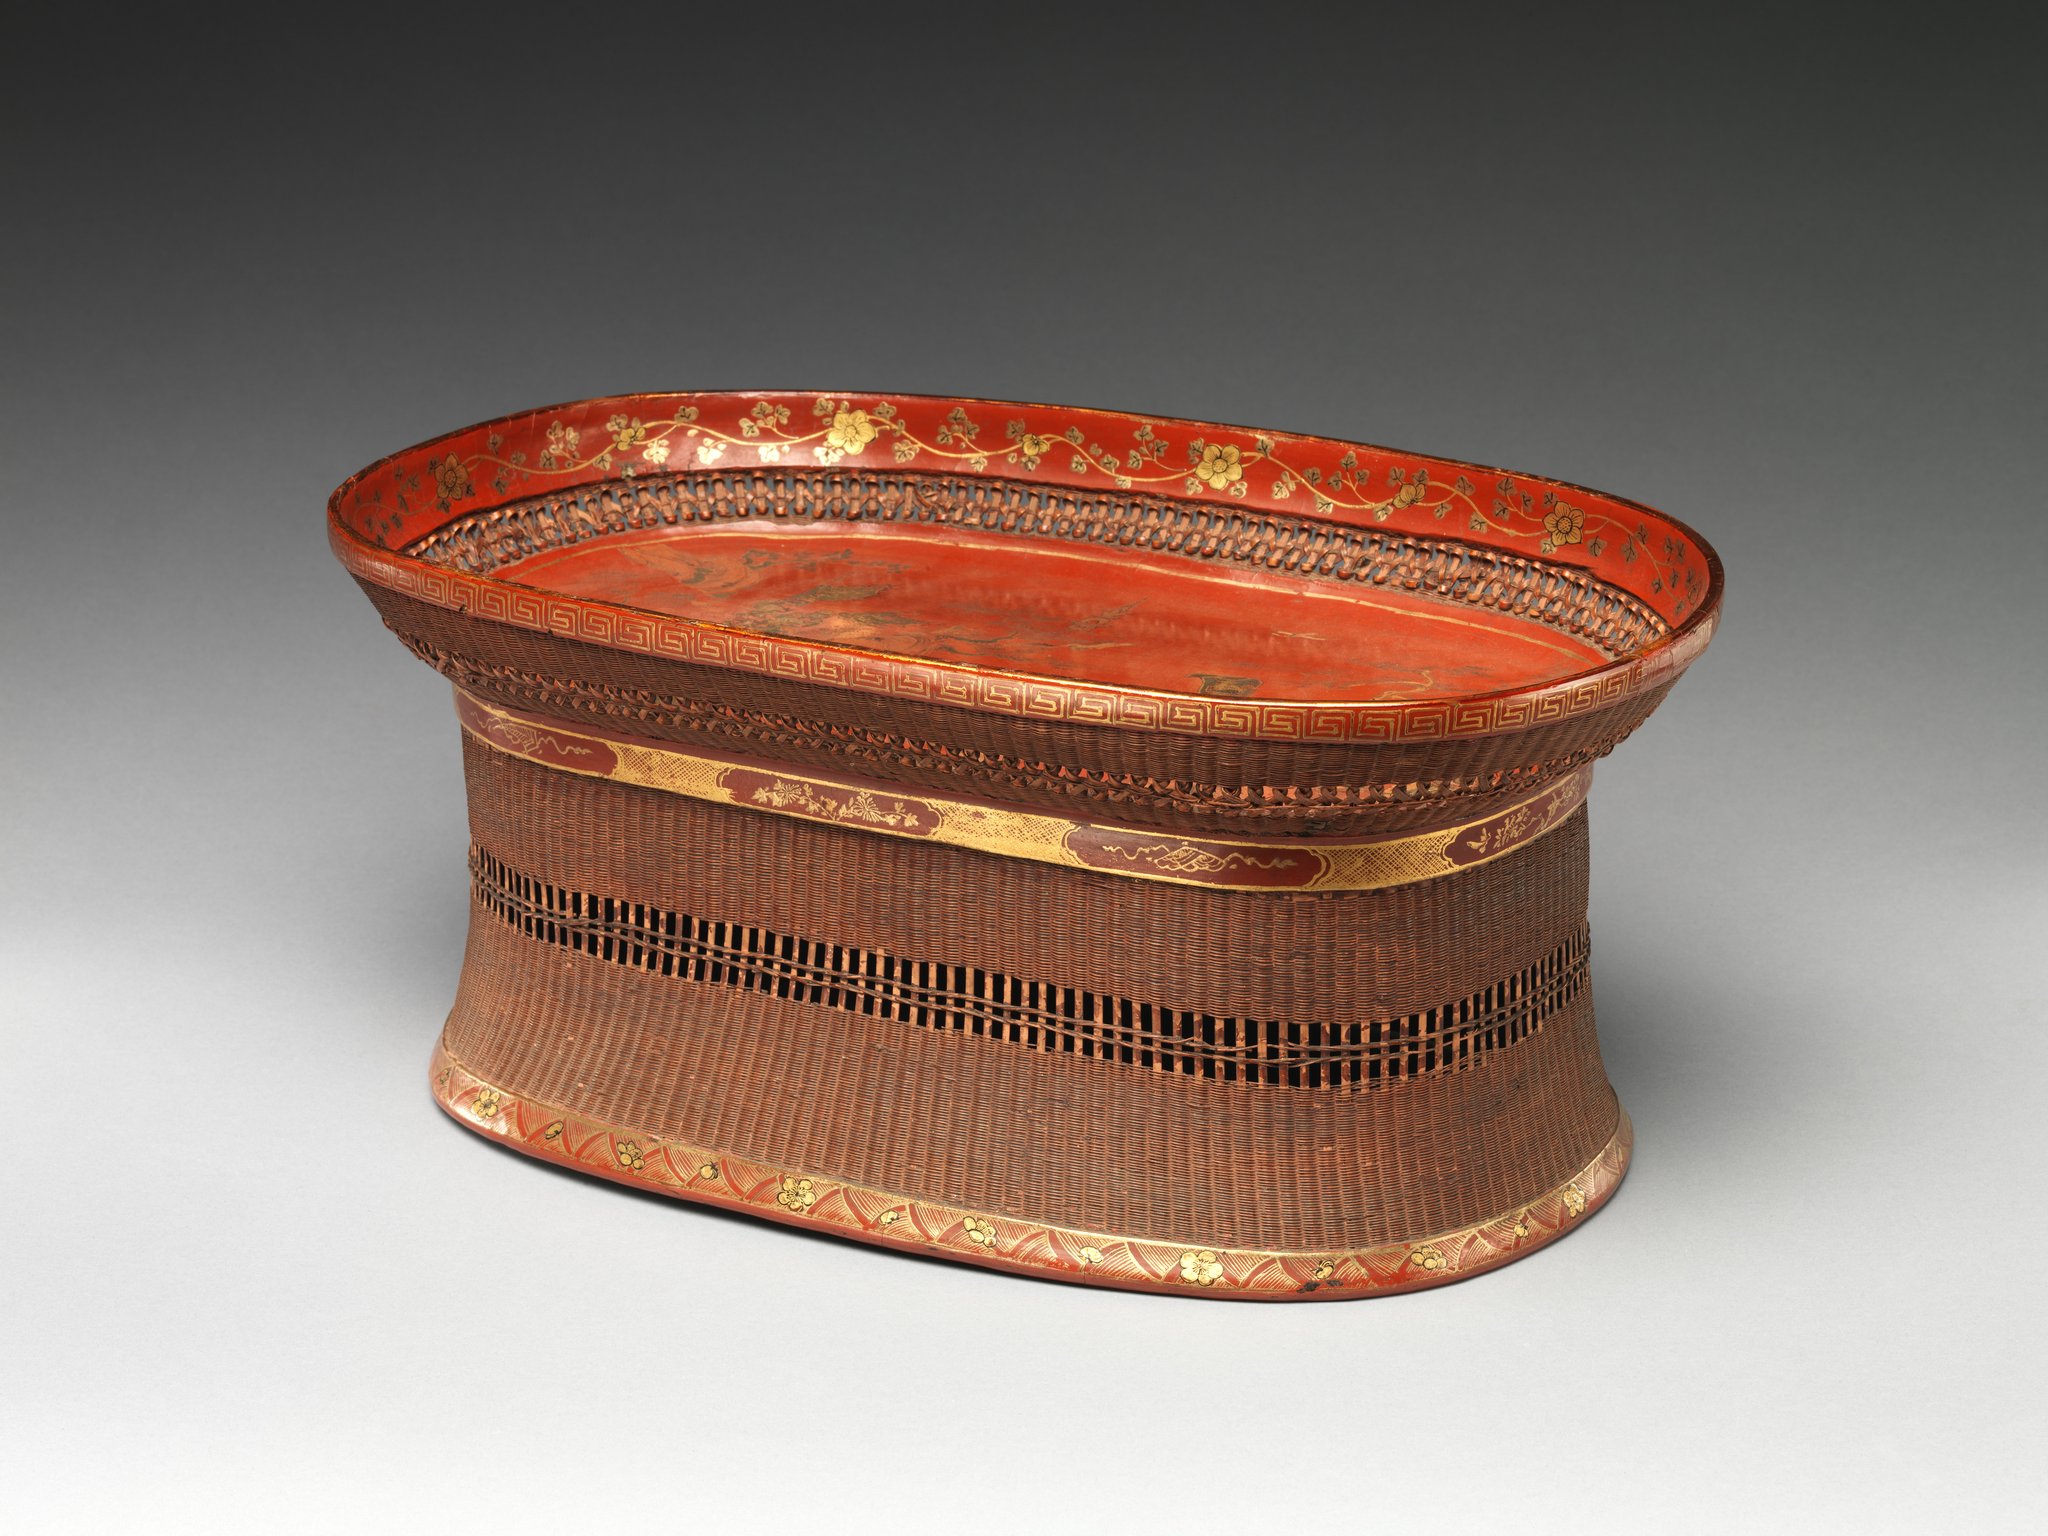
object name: footed tray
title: Footed Tray with Figures in a Landscape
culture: japanese or ryukyuan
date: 1601-1633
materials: gold, lacquer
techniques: painting